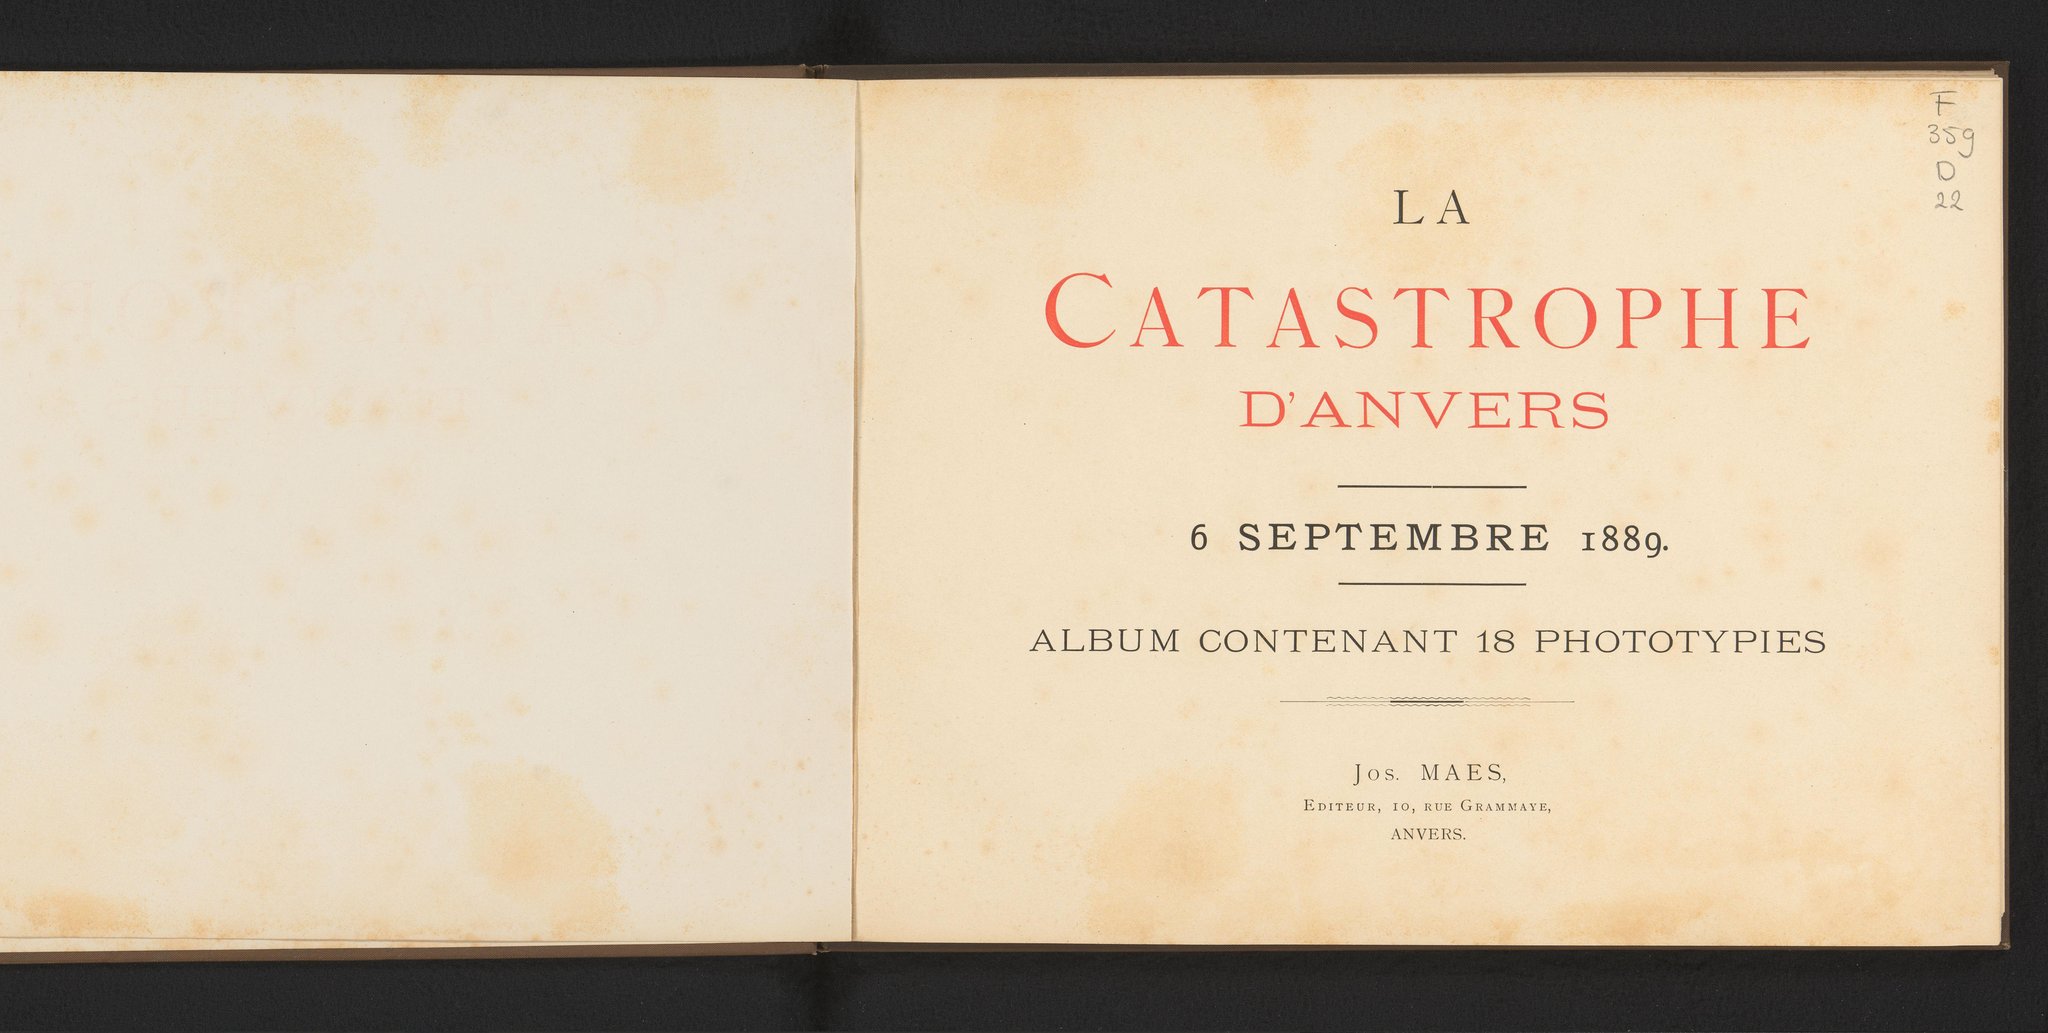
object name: book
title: La catastrophe d'Anvers 6 septembre 1889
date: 1889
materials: cardboard, linen, paper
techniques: photograph, printing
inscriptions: name: ‘Papeterie Librairie, Fournitures classiques J. Berkelmans 5. Rue des DouzeMois, 5 Anvers Imprimerie, Lithographie et Fres de Bureau Reliure’